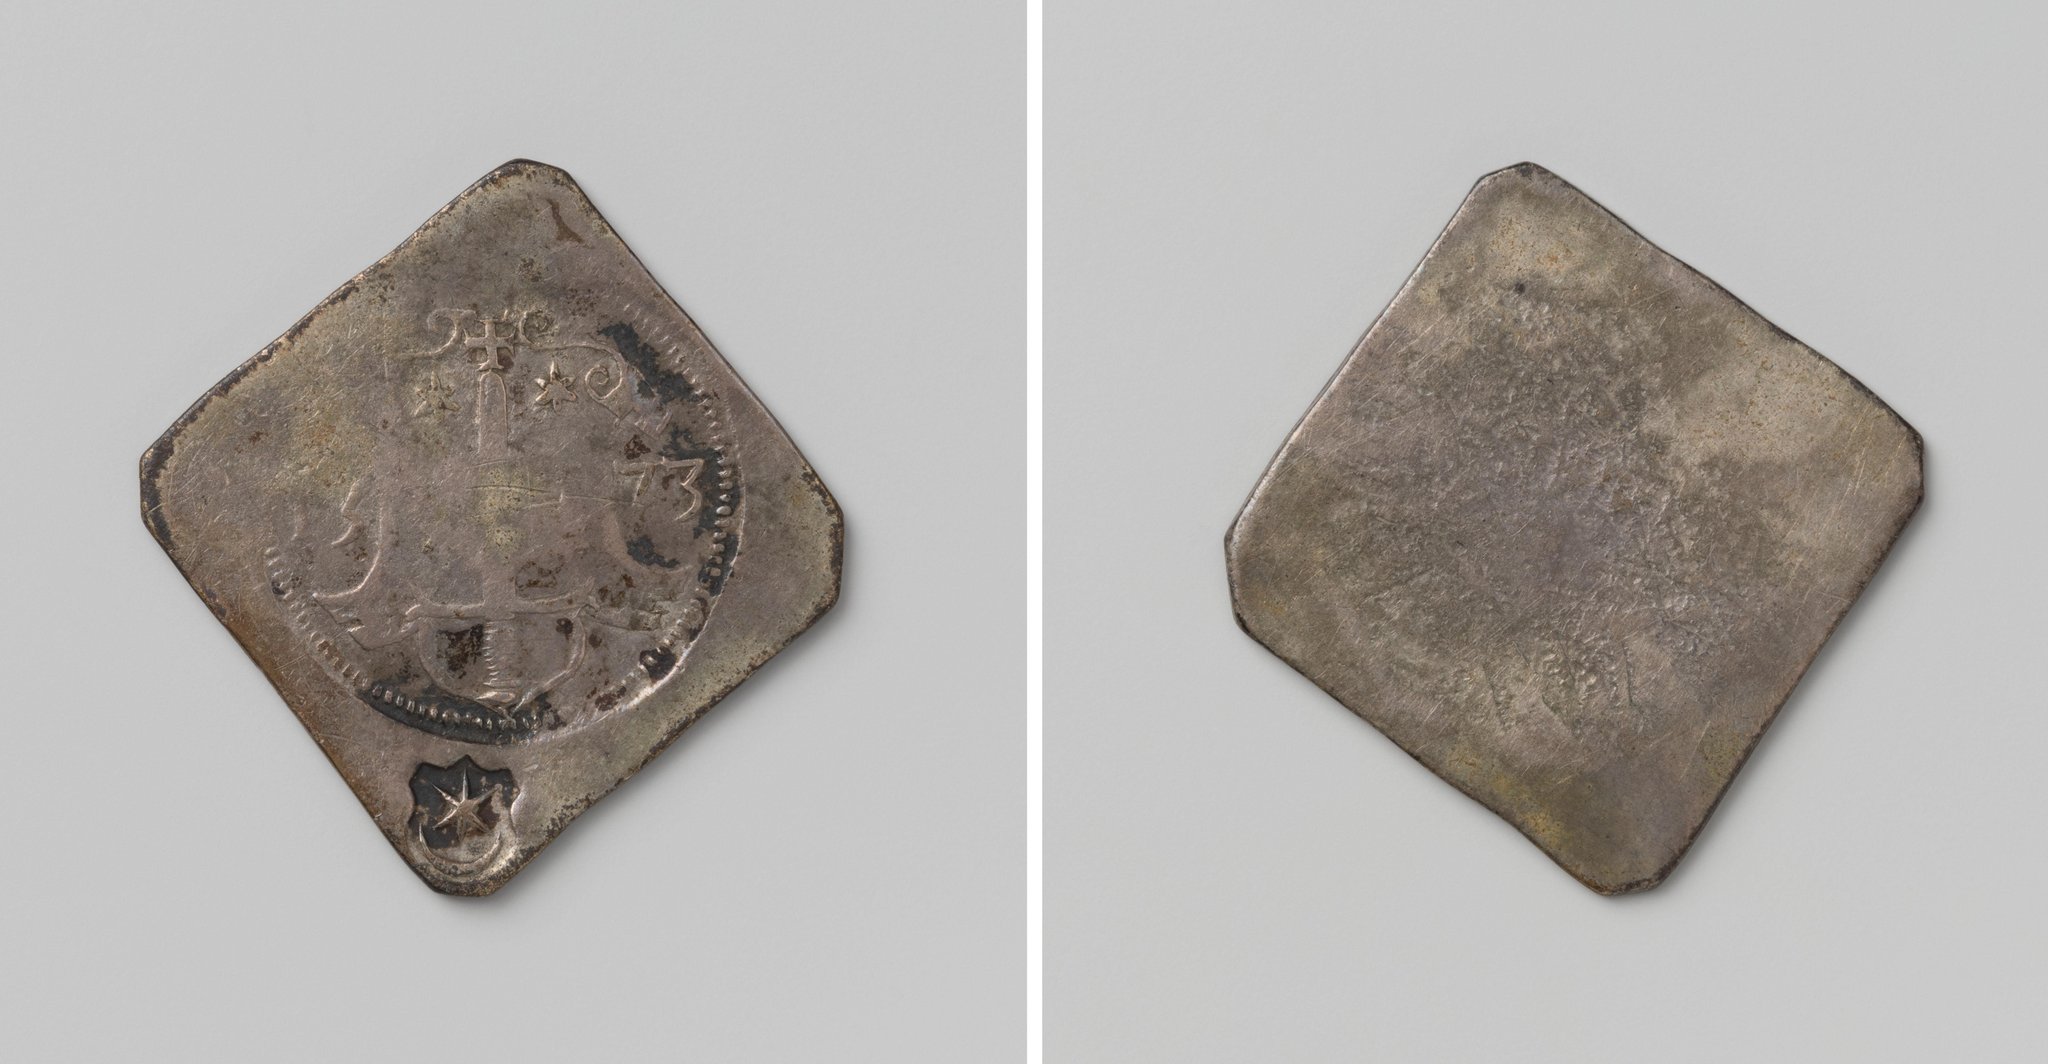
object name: siege coin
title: Halve gulden, noodmunt uit Haarlem, geslagen tijdens het beleg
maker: Anonymous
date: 1573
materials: silver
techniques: striking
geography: haarlem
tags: haarlem